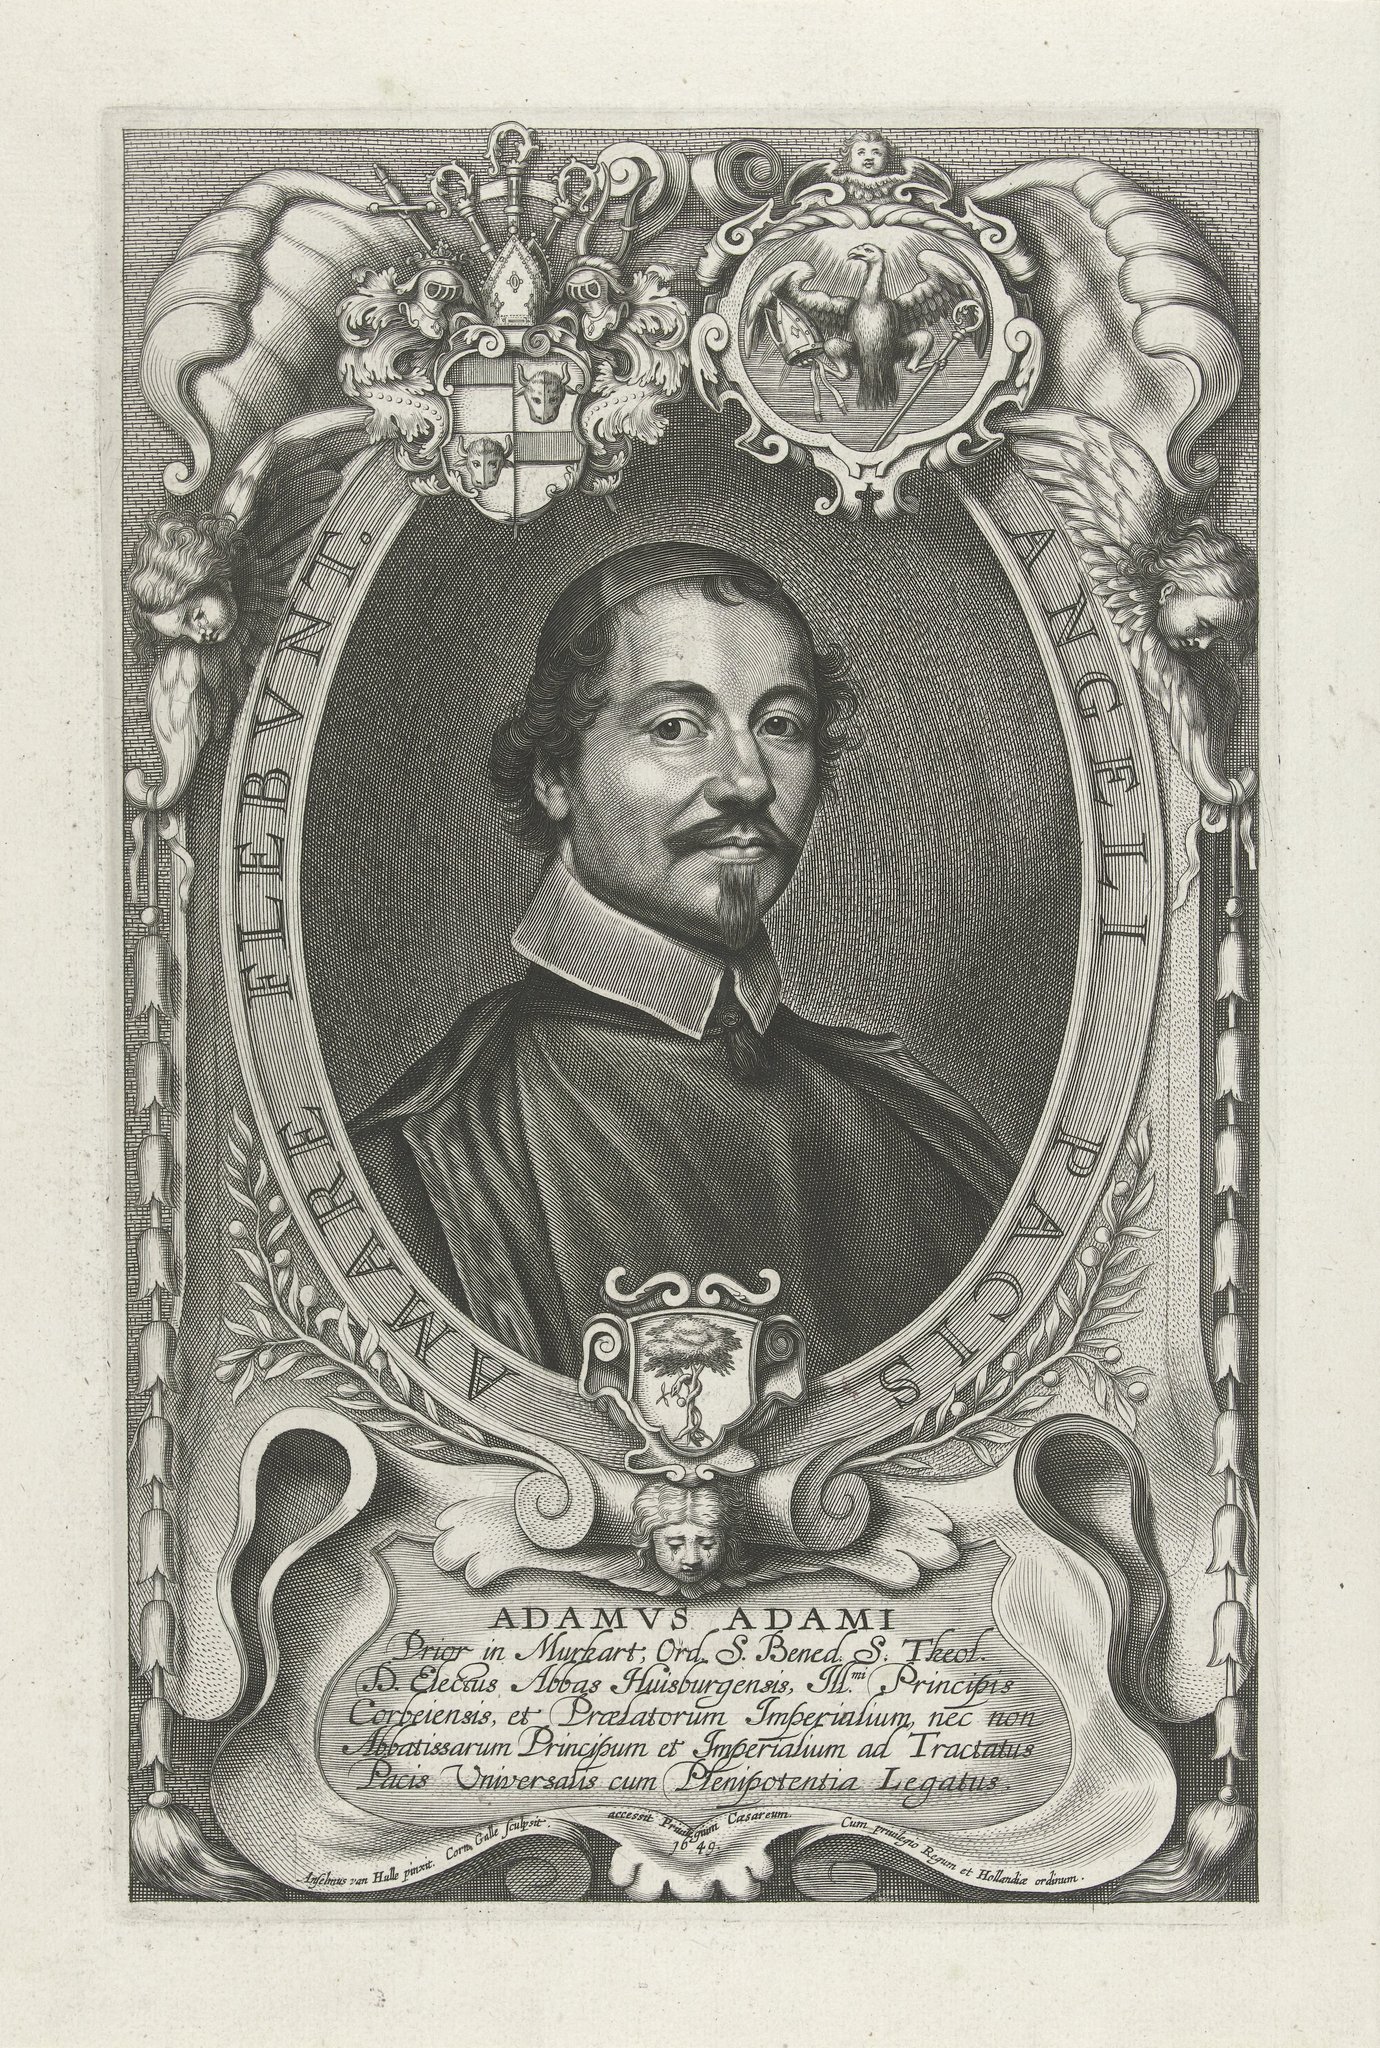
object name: watercolor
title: Tros witte druiven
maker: jean bernard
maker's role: draughtsman, print maker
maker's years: 1765-1833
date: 1775-1833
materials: paper, pencil, watercolor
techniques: brush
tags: bunch of grapes